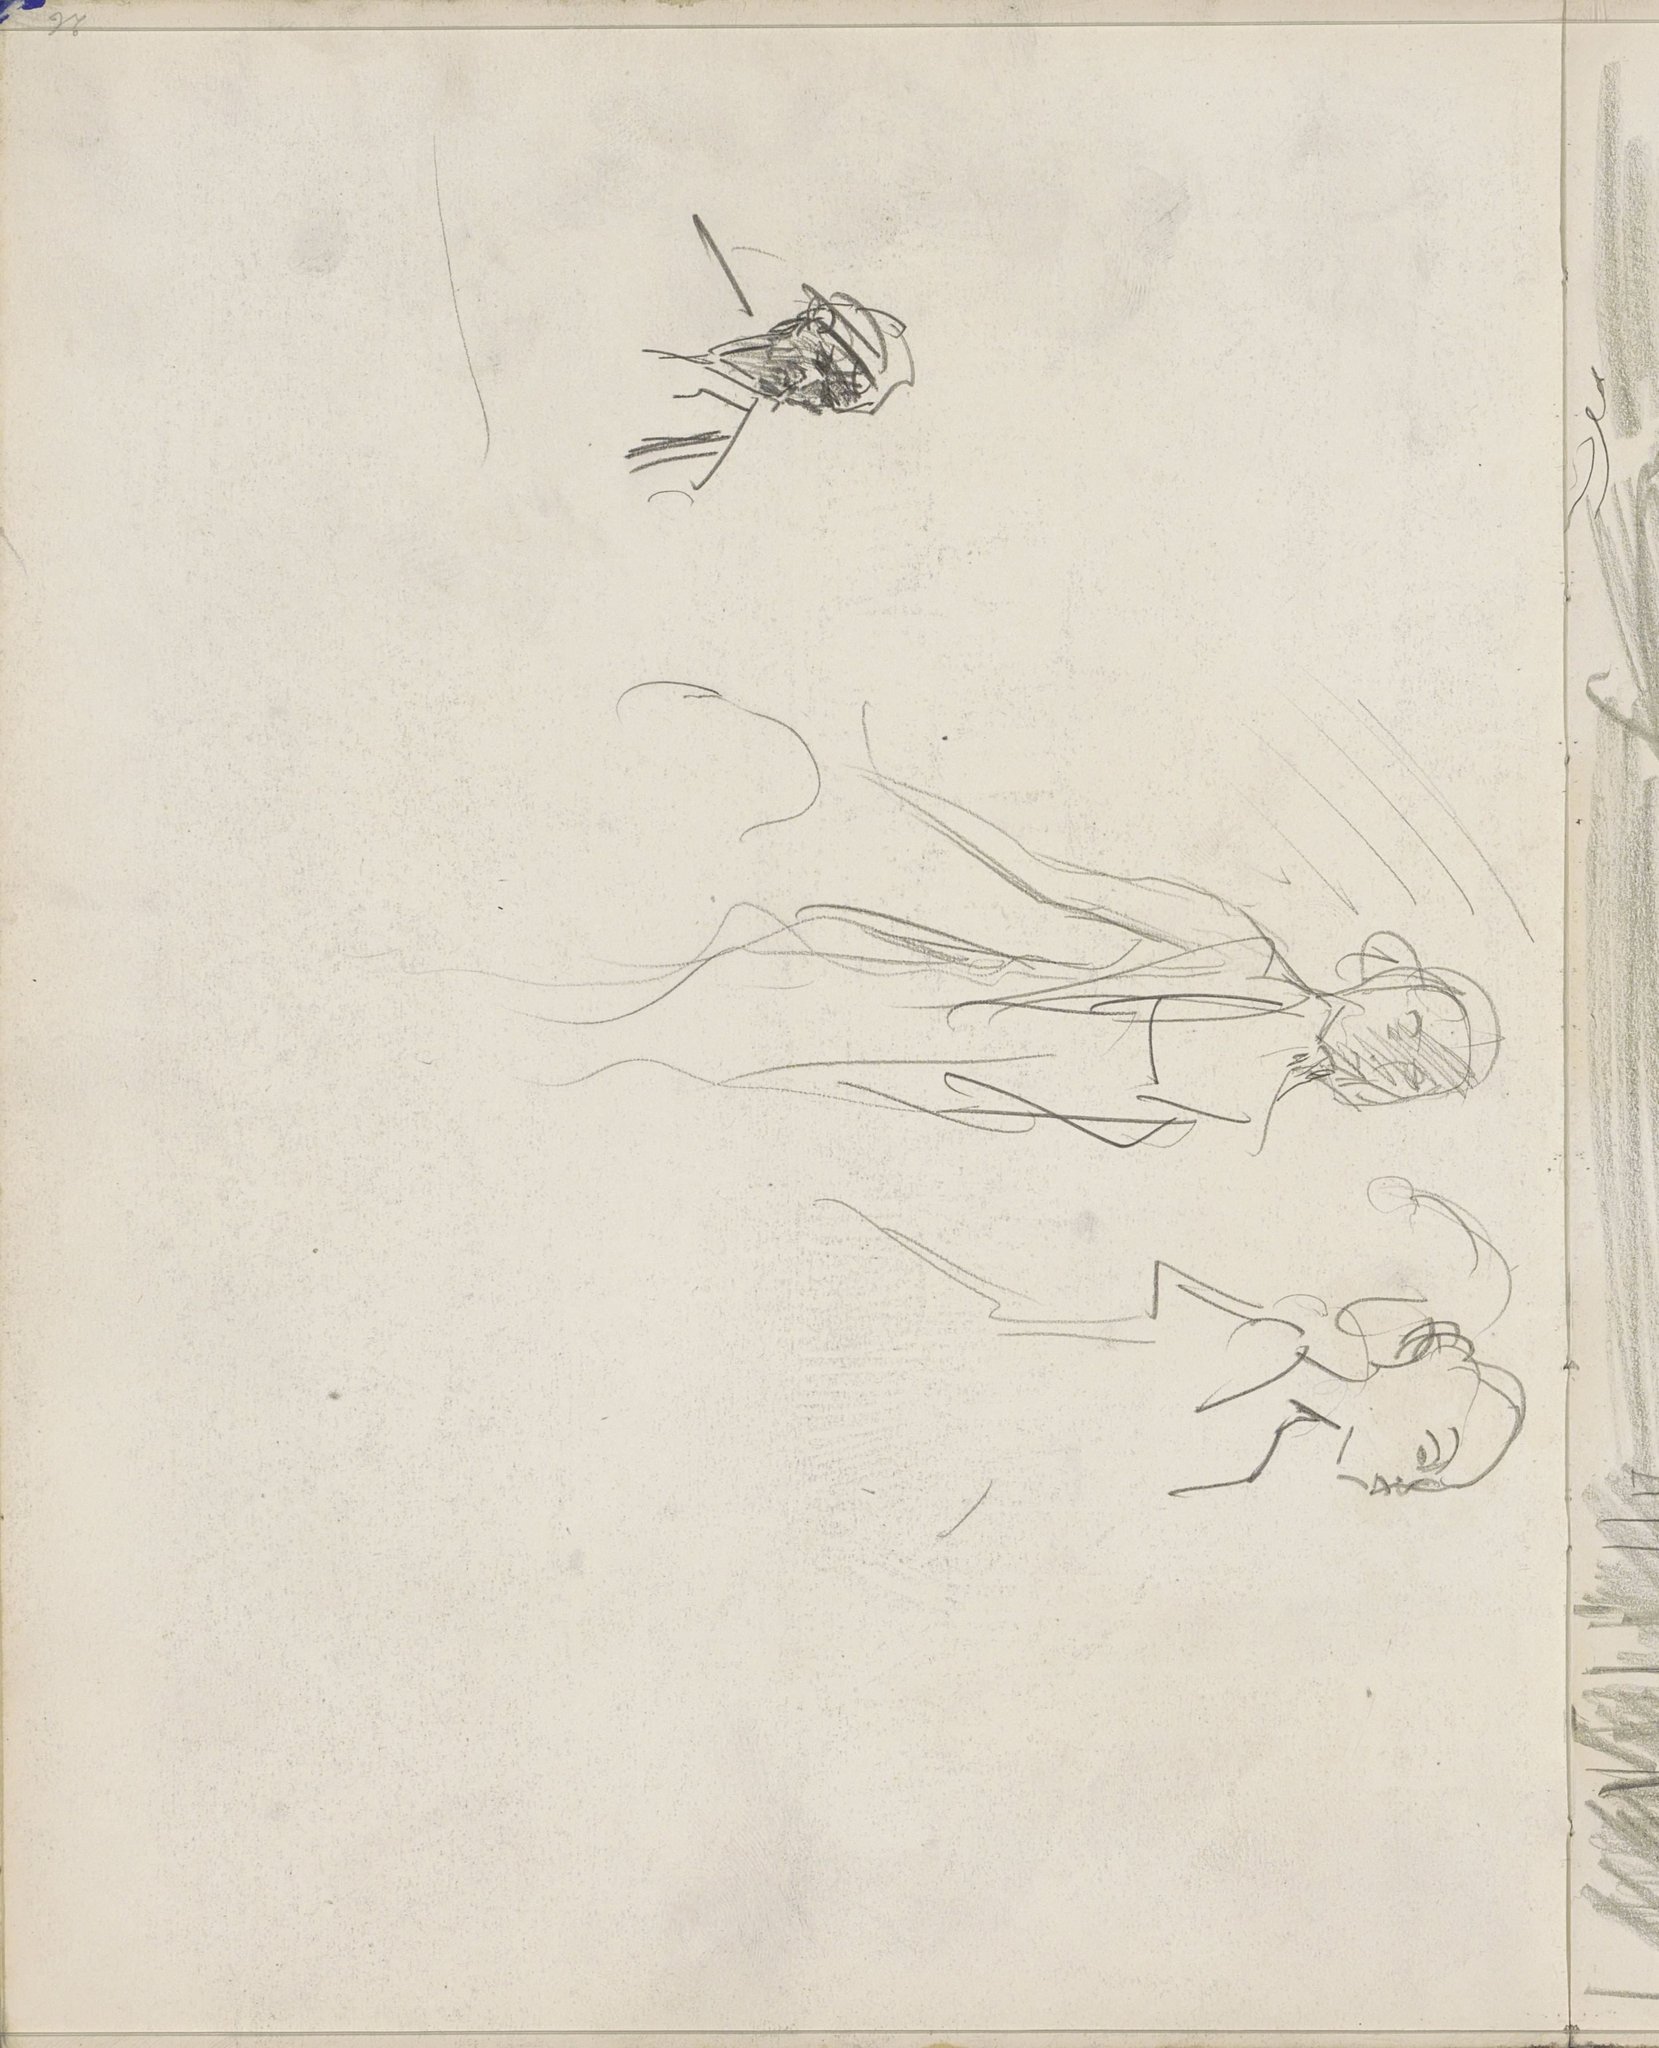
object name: sketchbook leaf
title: Studieblad met een mannenbuste en twee danseressen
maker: isaac israels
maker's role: draughtsman, painter, print maker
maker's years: 1865-1934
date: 1921-1922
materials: paper, pencil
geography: dutch east indies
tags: asiatic races and peoples, adult man, female dancer, dutch east indies, the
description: Blad 19 verso uit schetsboek XIX met 22 bladen.